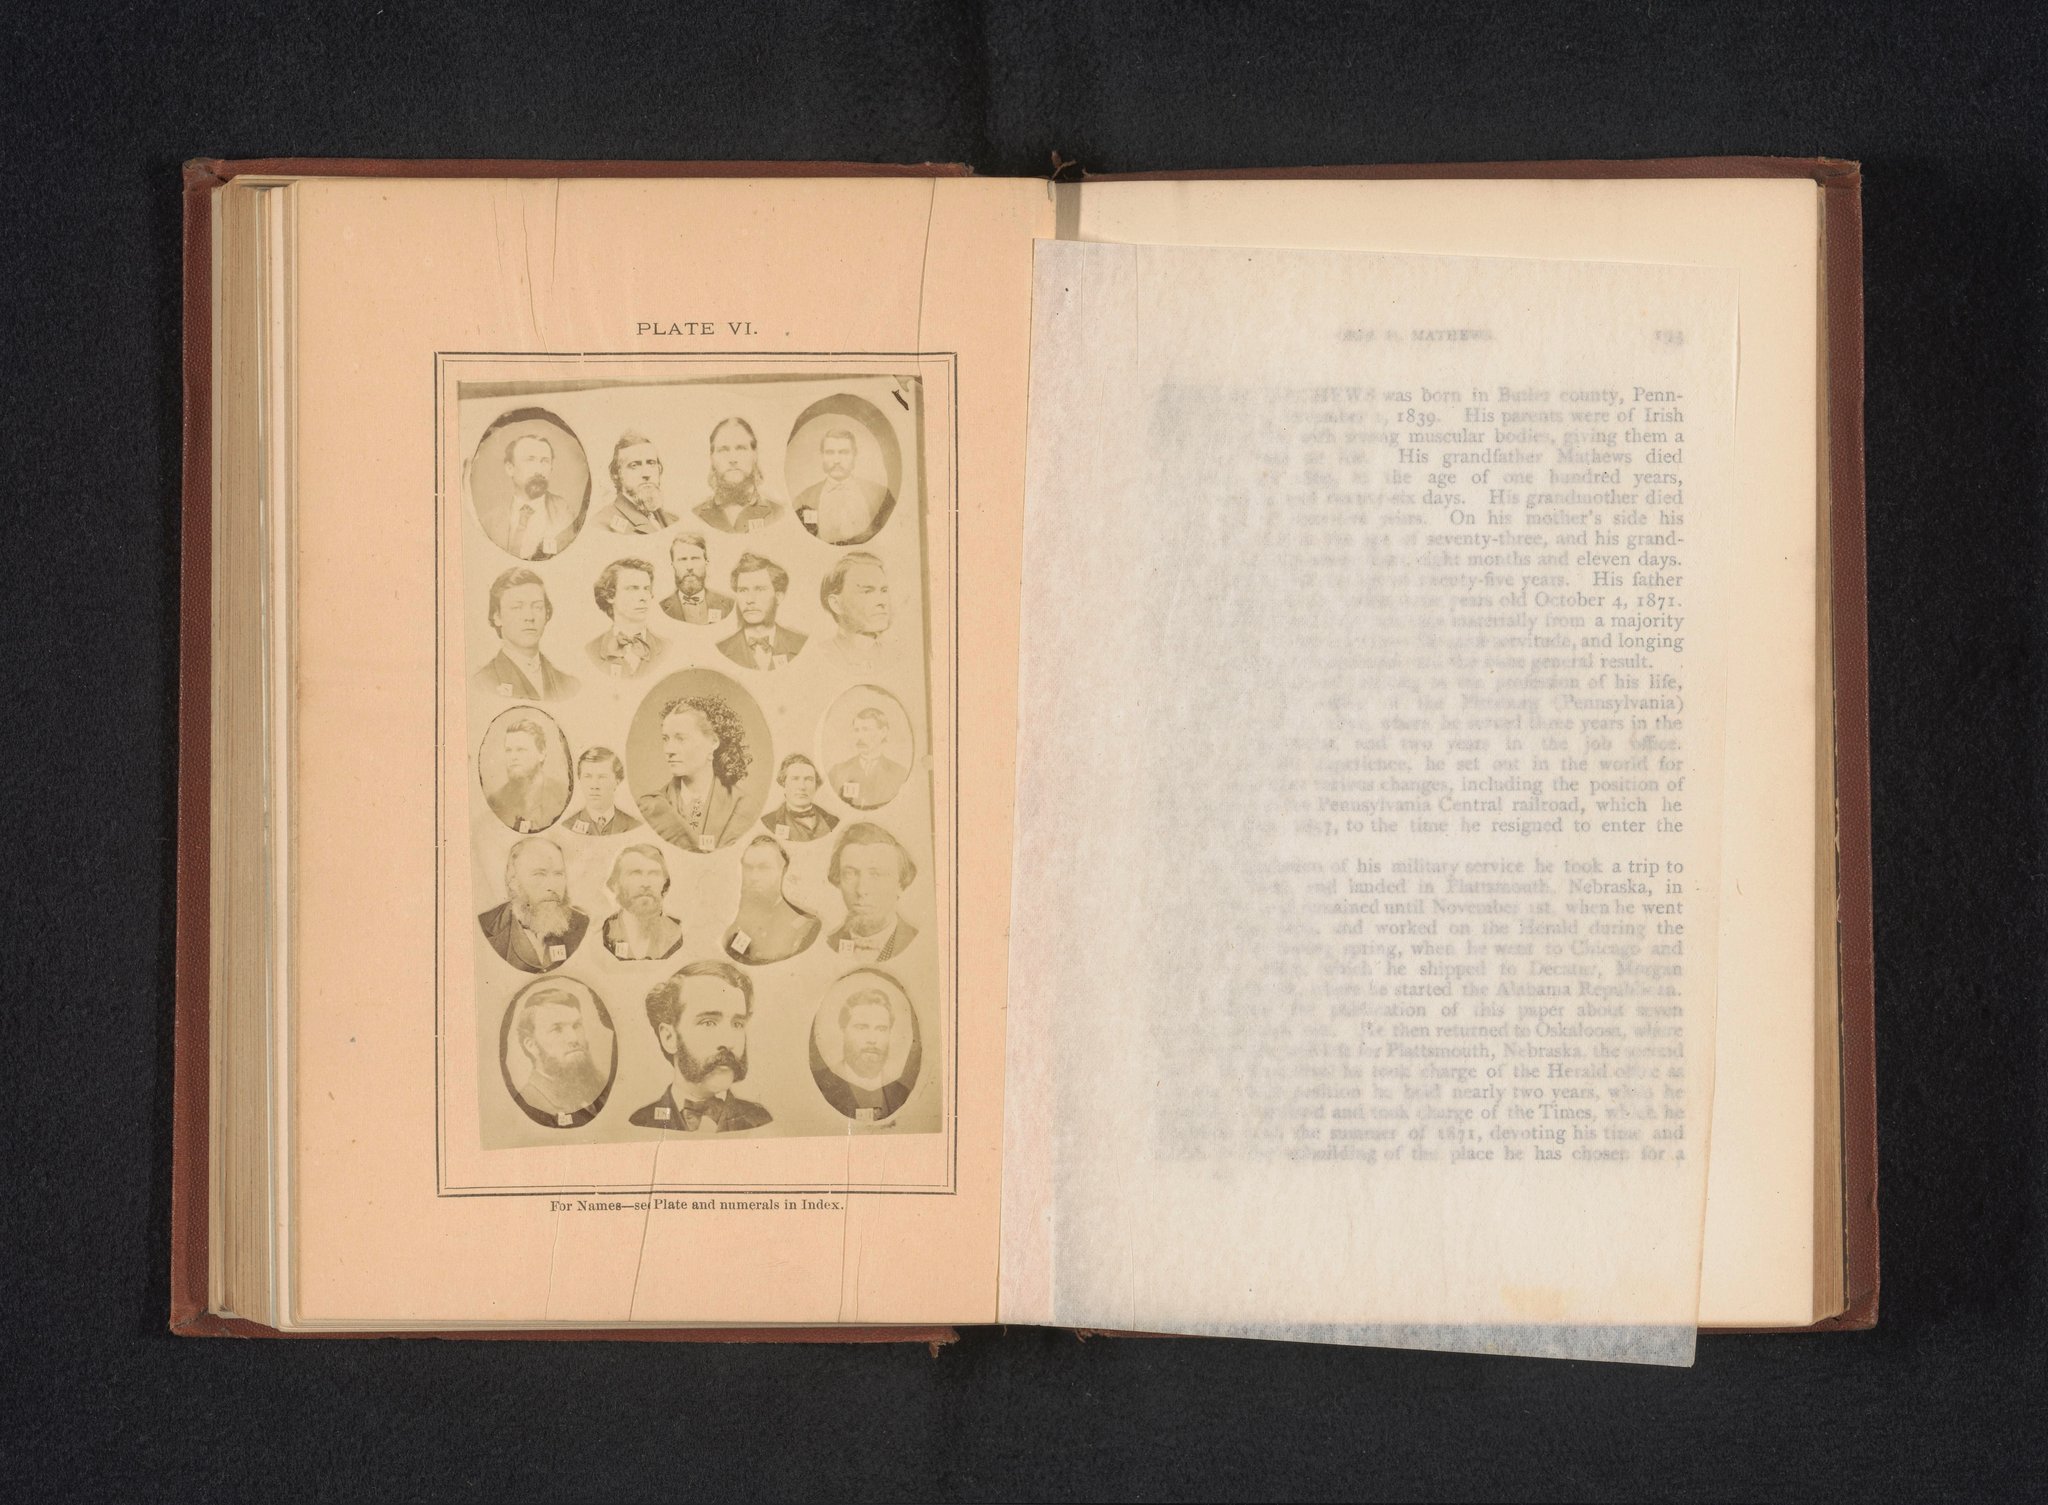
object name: photomontage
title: Fotomontage van 21 Amerikaanse politici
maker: edric l. eaton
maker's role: fotograaf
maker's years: 1835-1890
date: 1866-1871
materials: photographic support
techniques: albumen print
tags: politician, new york, london, historical persons, politician, e.g. party leader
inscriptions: inscription: ‘For Names, see Plate and numerals in Index’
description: Foto tegenover pagina 164, zie index voor overige namen.